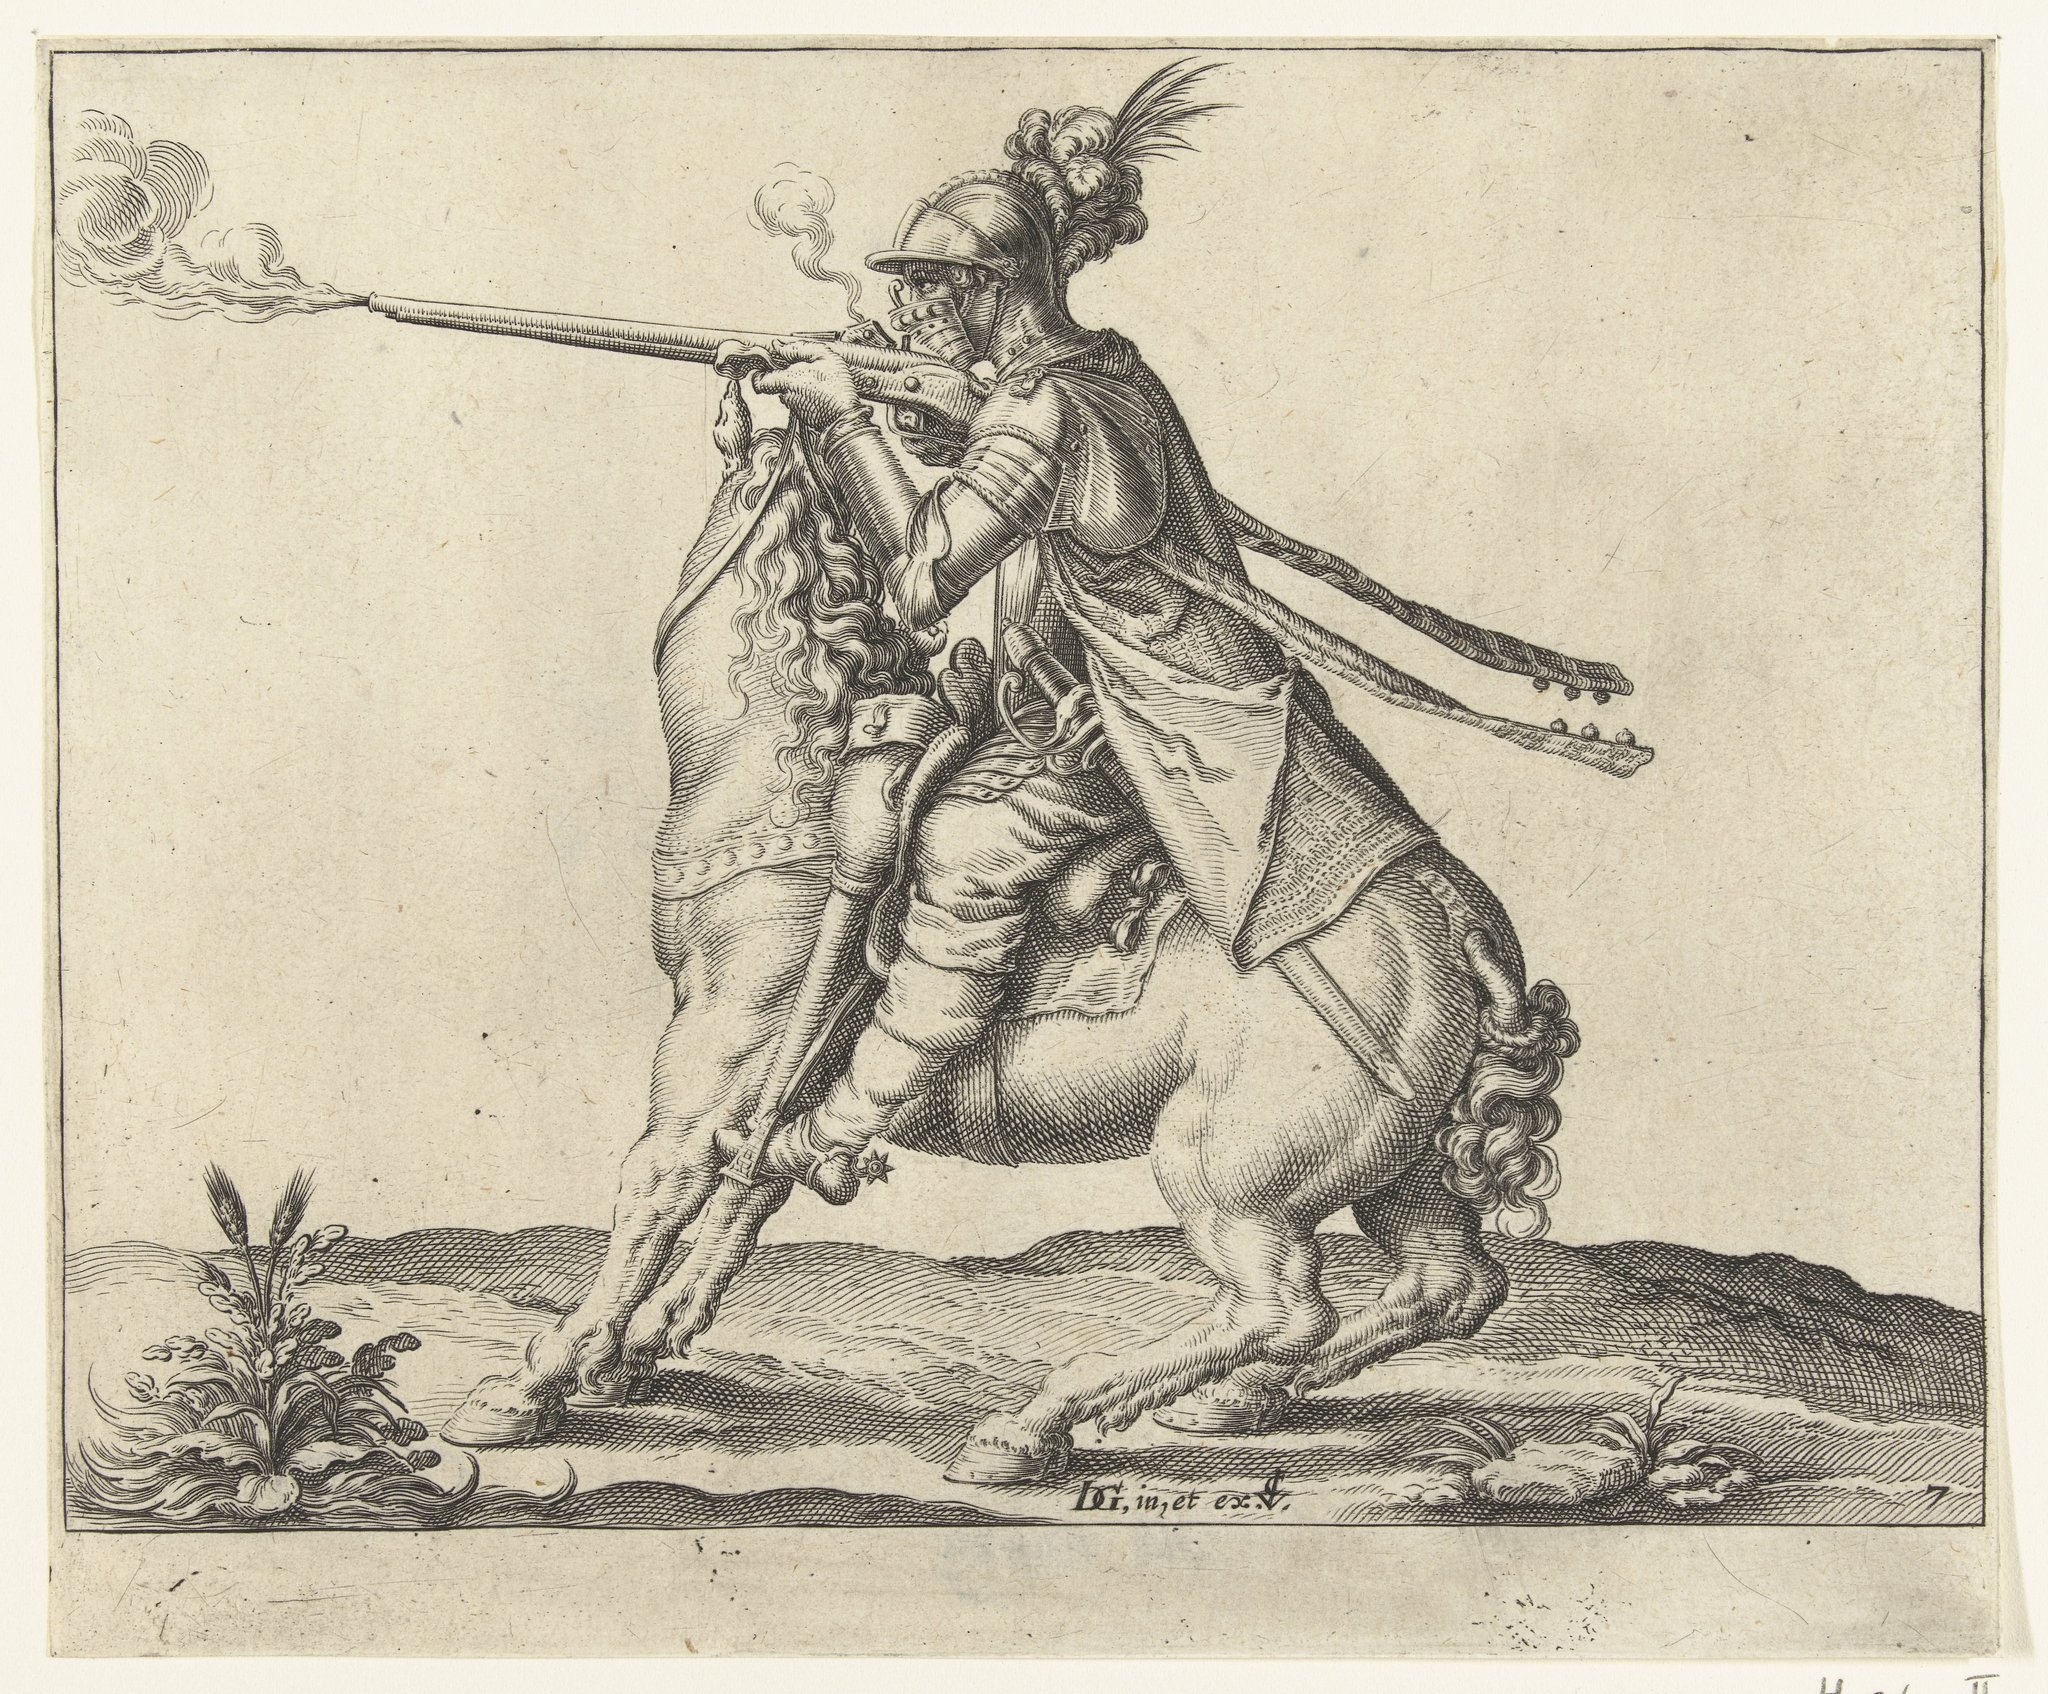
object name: print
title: De ruiterschool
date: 1599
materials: paper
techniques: engraving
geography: leiden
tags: warfare; military affairs (+ cavalry, horsemen), firearms: rifle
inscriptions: collector's mark: Lugt 2228a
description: Een geharnaste man te paard, naar links een schot vurend met een harquebus (licht type geweer). Deze prent is onderdeel van een serie van 22 genummerde prenten: een titelprent, 20 prenten waarop één of enkele verschillende typen (meest geharnaste) ruiters zijn weergegeven, en een prent met een ruitergevecht.